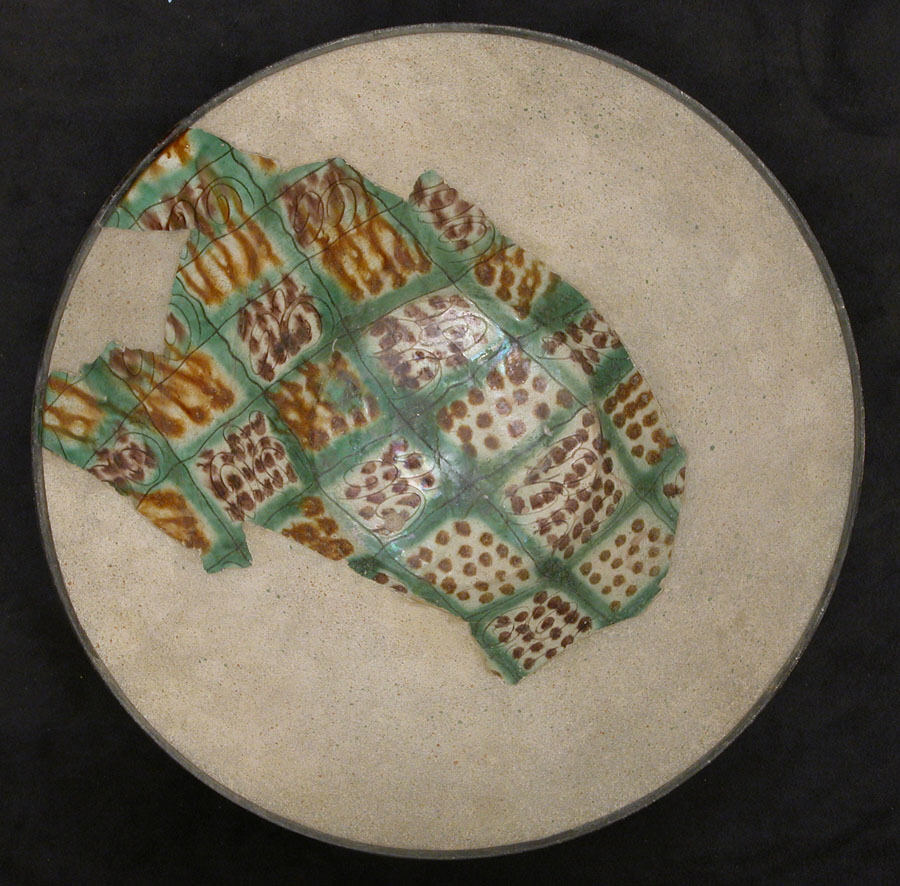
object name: bowl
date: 767-833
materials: earthenware, glaze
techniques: incising, polychrome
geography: iran